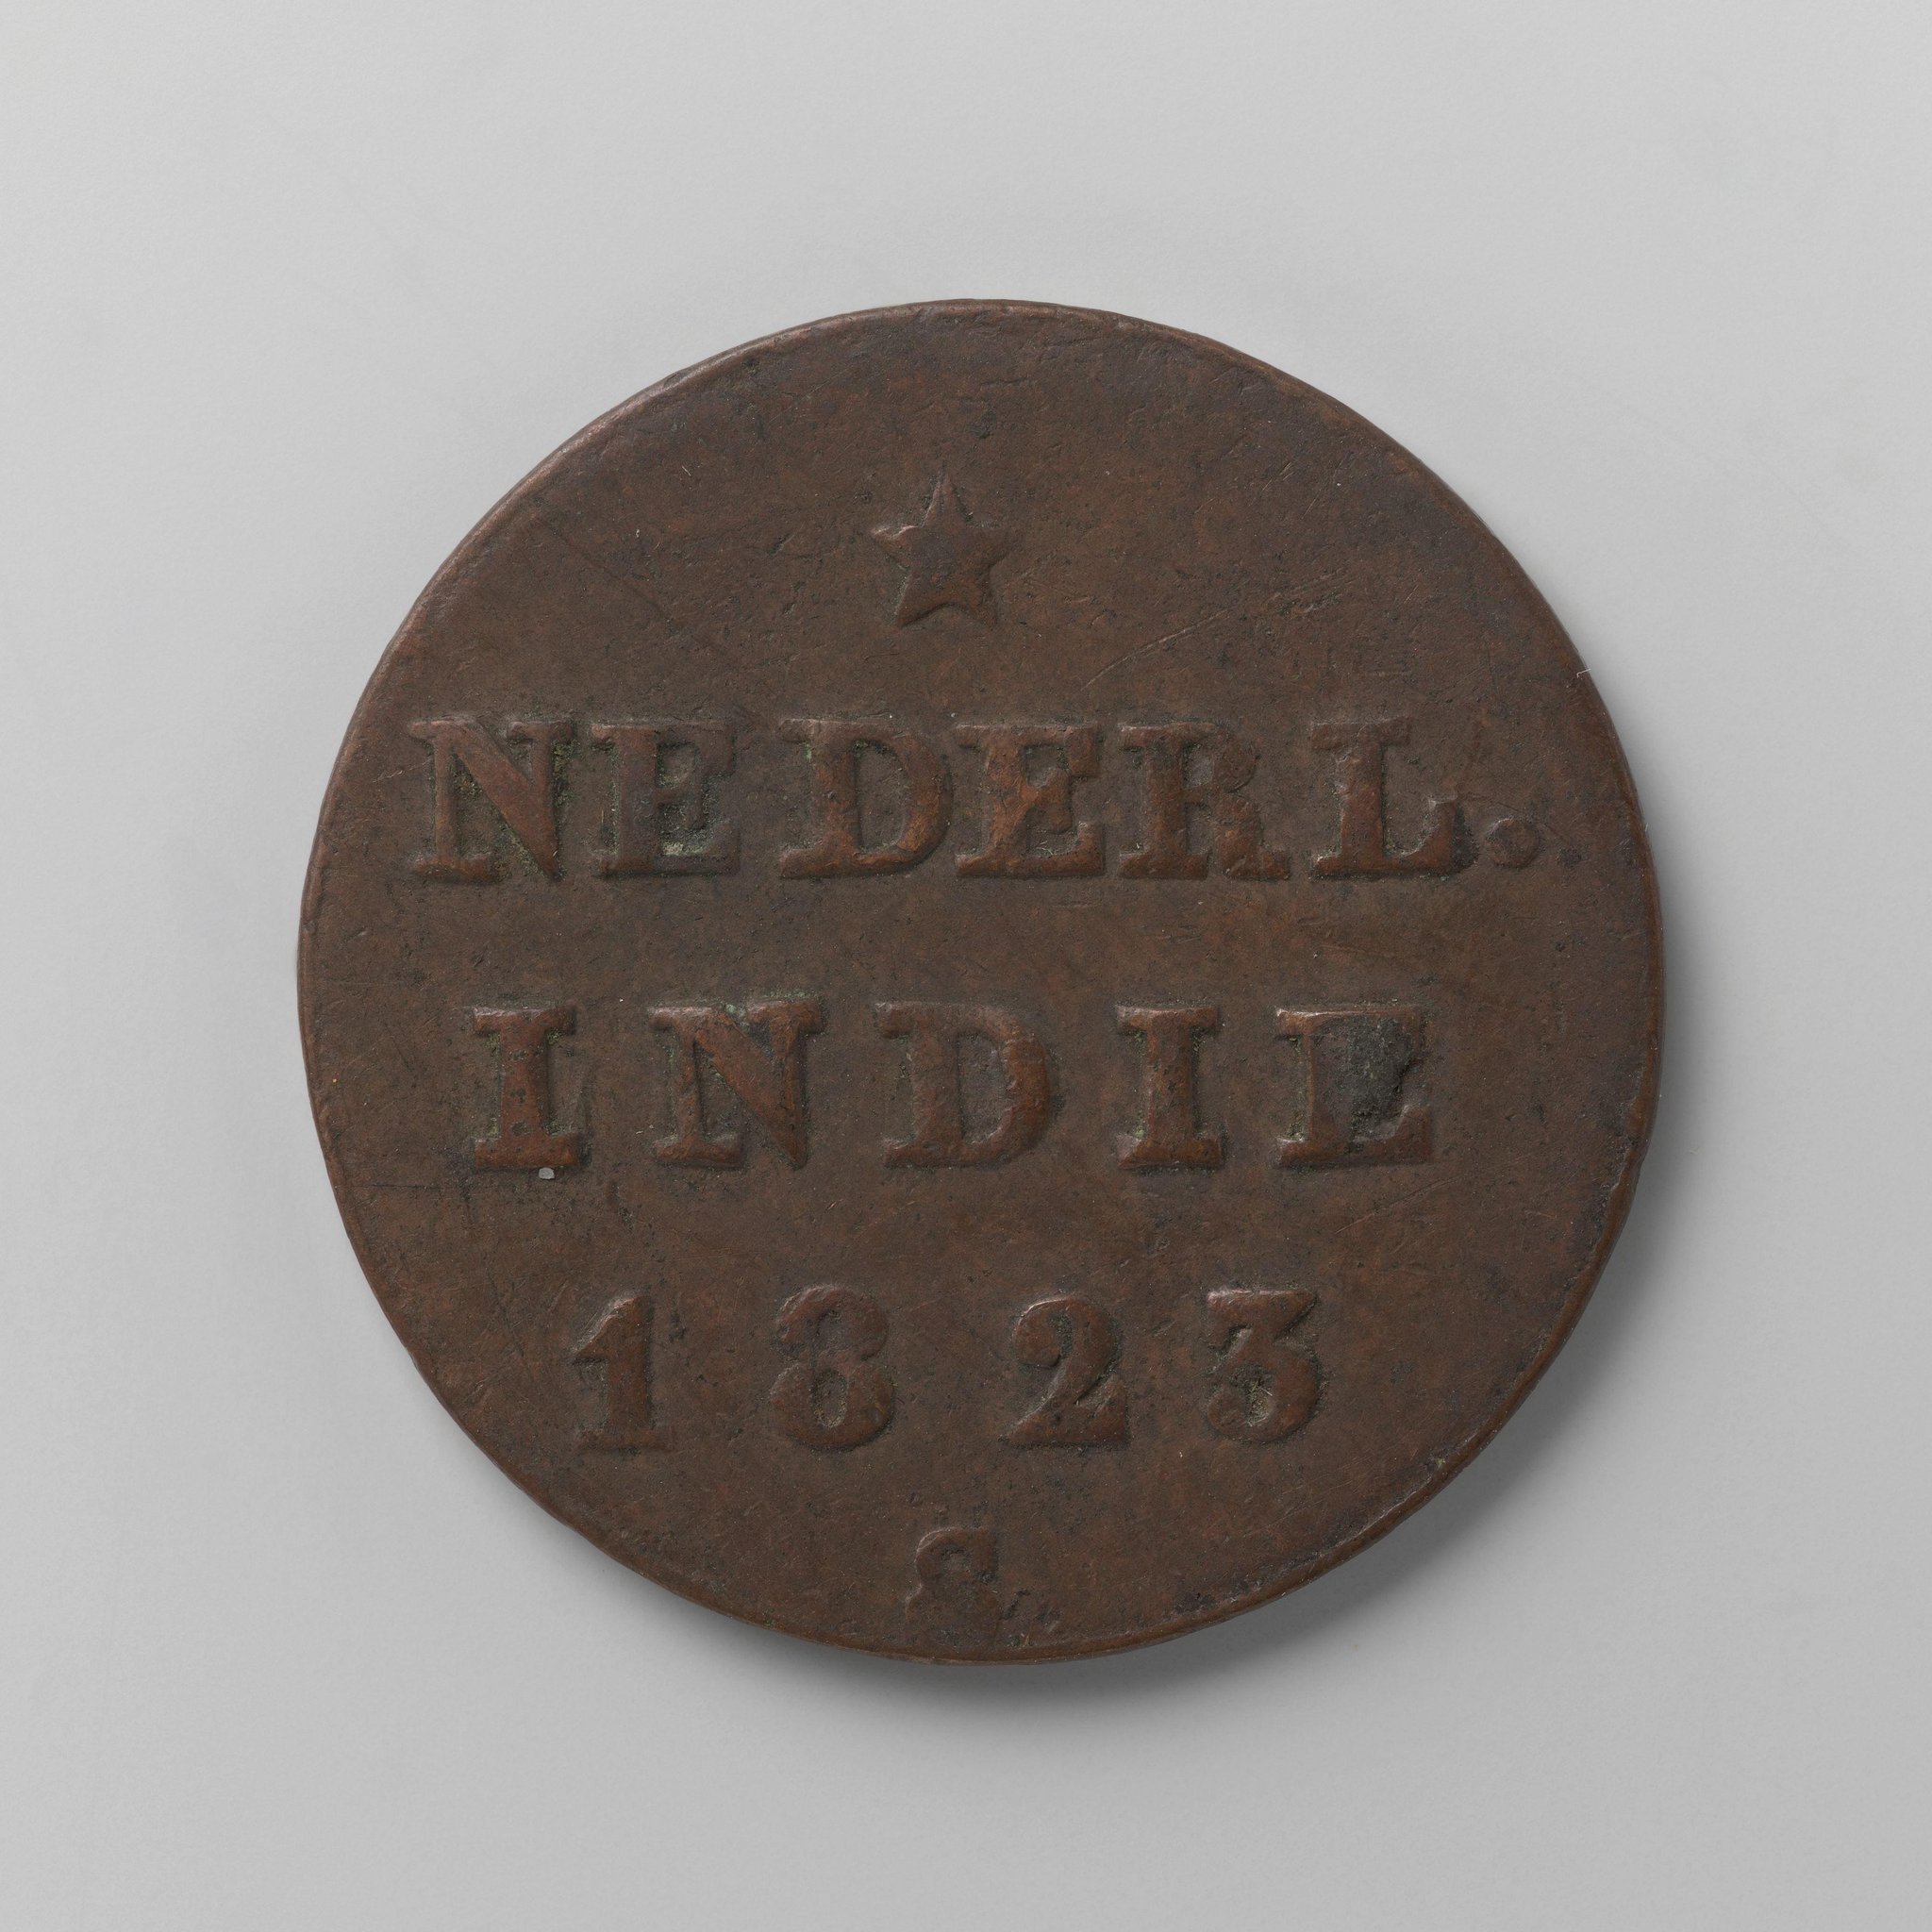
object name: coin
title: ½ stuiver van Nederlands Indië, 1823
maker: william i of the netherlands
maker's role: koning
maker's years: 1772-1843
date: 1823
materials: copper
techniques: striking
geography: utrecht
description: Koperen munt. Voorzijde: tussen waarde-aanduiding ½ St. gekroond rijkswapenschild. Keerzijde: tweeregelig opschrift, waarboven muntteken en waaronder jaartal. Daaronder muntmeesterteken S [=Suermondt]. Gladde rand.